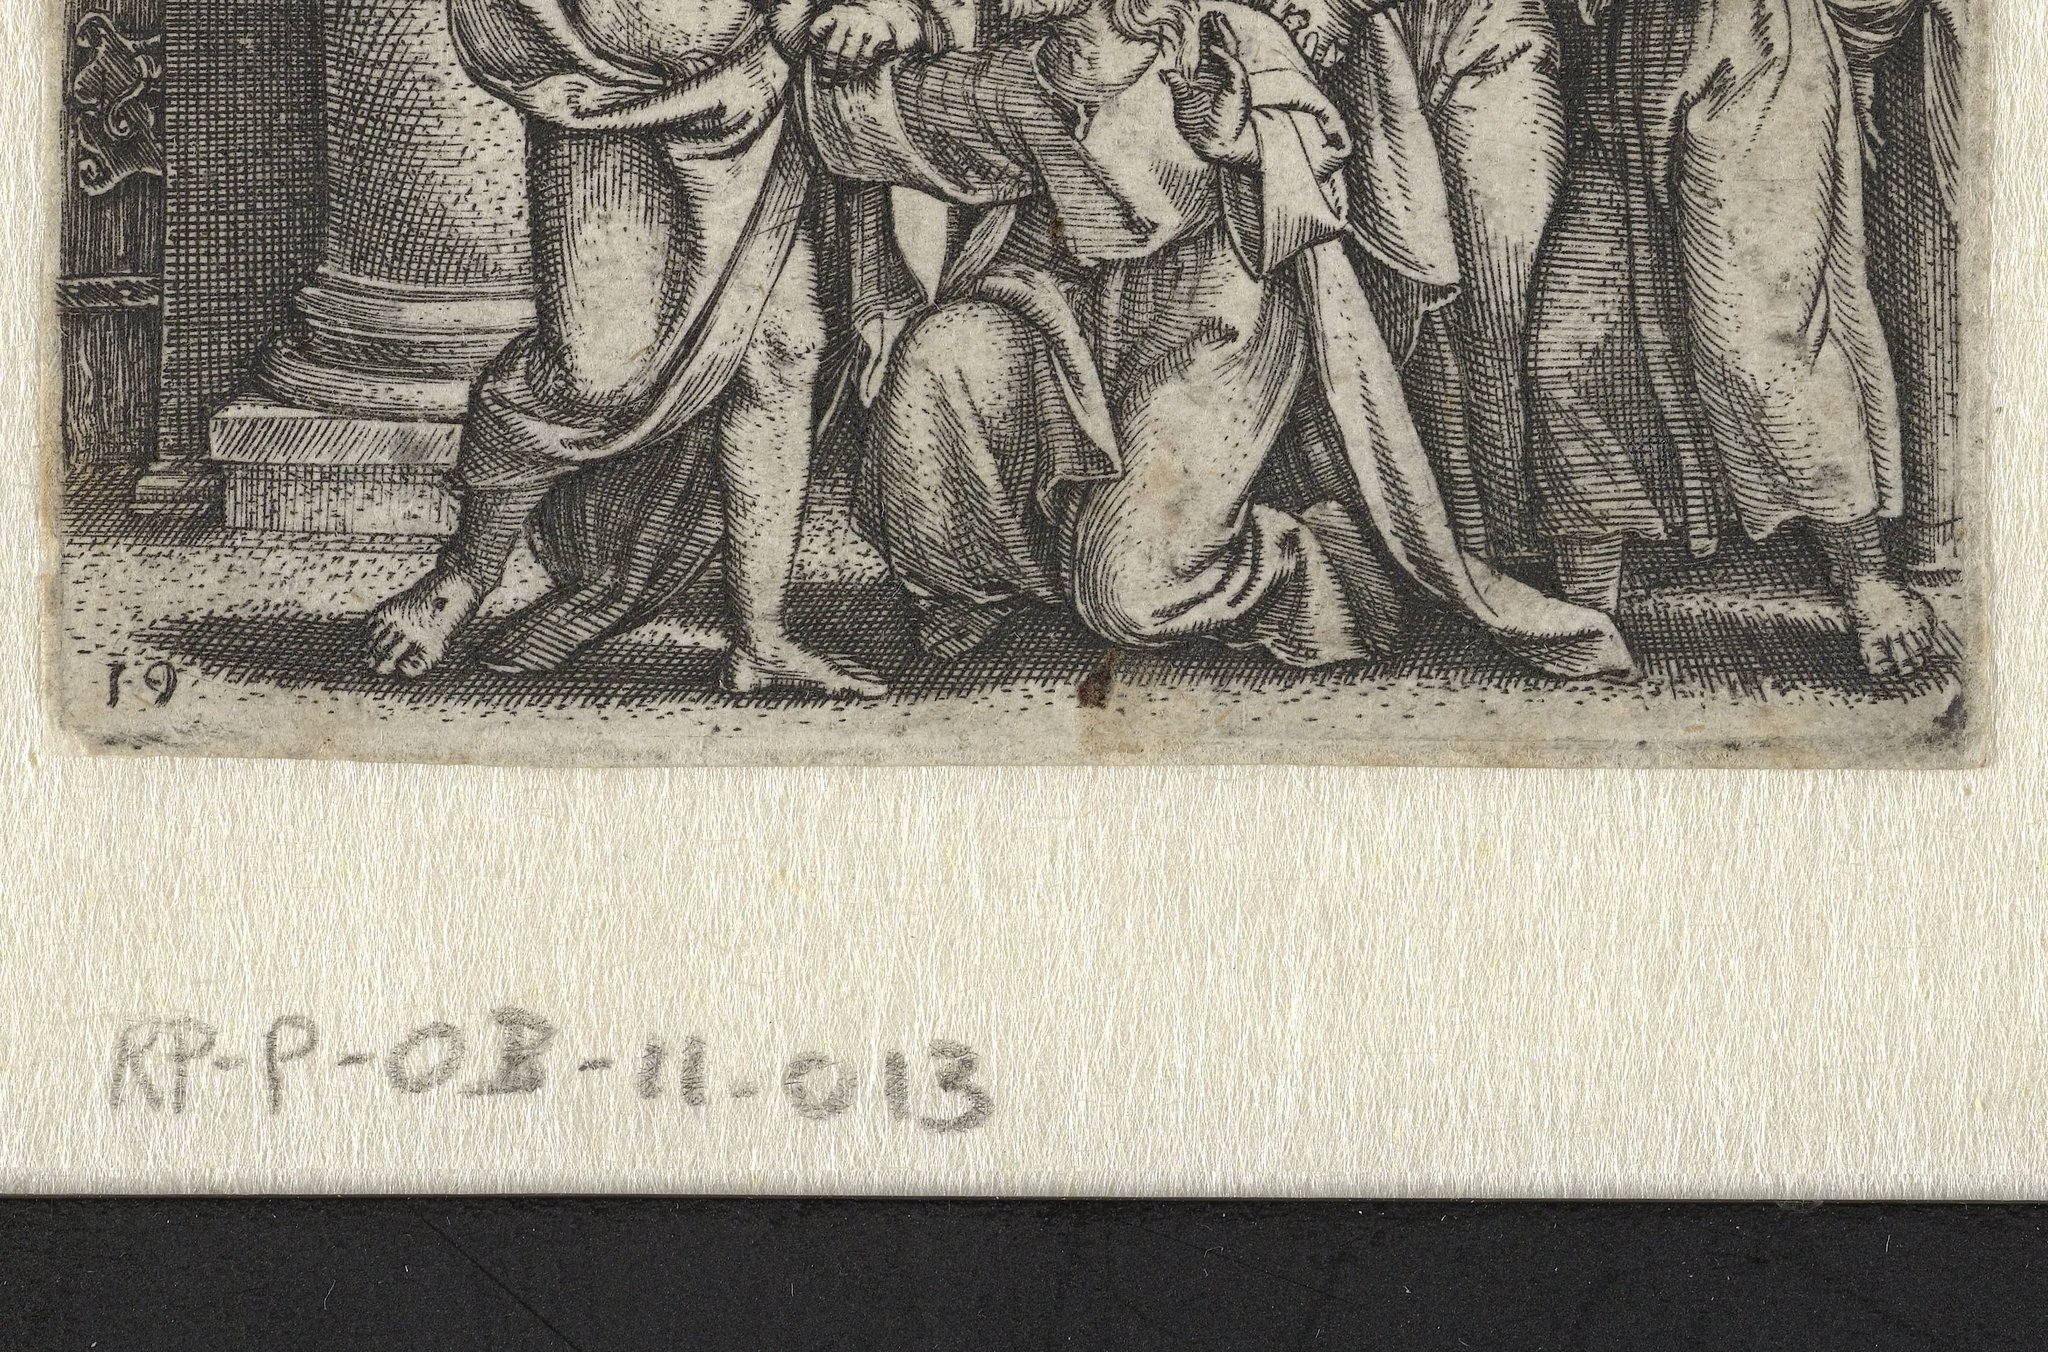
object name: print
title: Ongelovige Thomas raakt wonden Christus aan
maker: georg pencz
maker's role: draughtsman, painter, print maker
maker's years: 1500-1550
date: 1534-1535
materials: paper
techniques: engraving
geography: germany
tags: thomas touching or stretching out his hands to touch the wound in christ's side, sometimes christ leading thomas' hand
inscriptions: collector's mark: Lugt 240